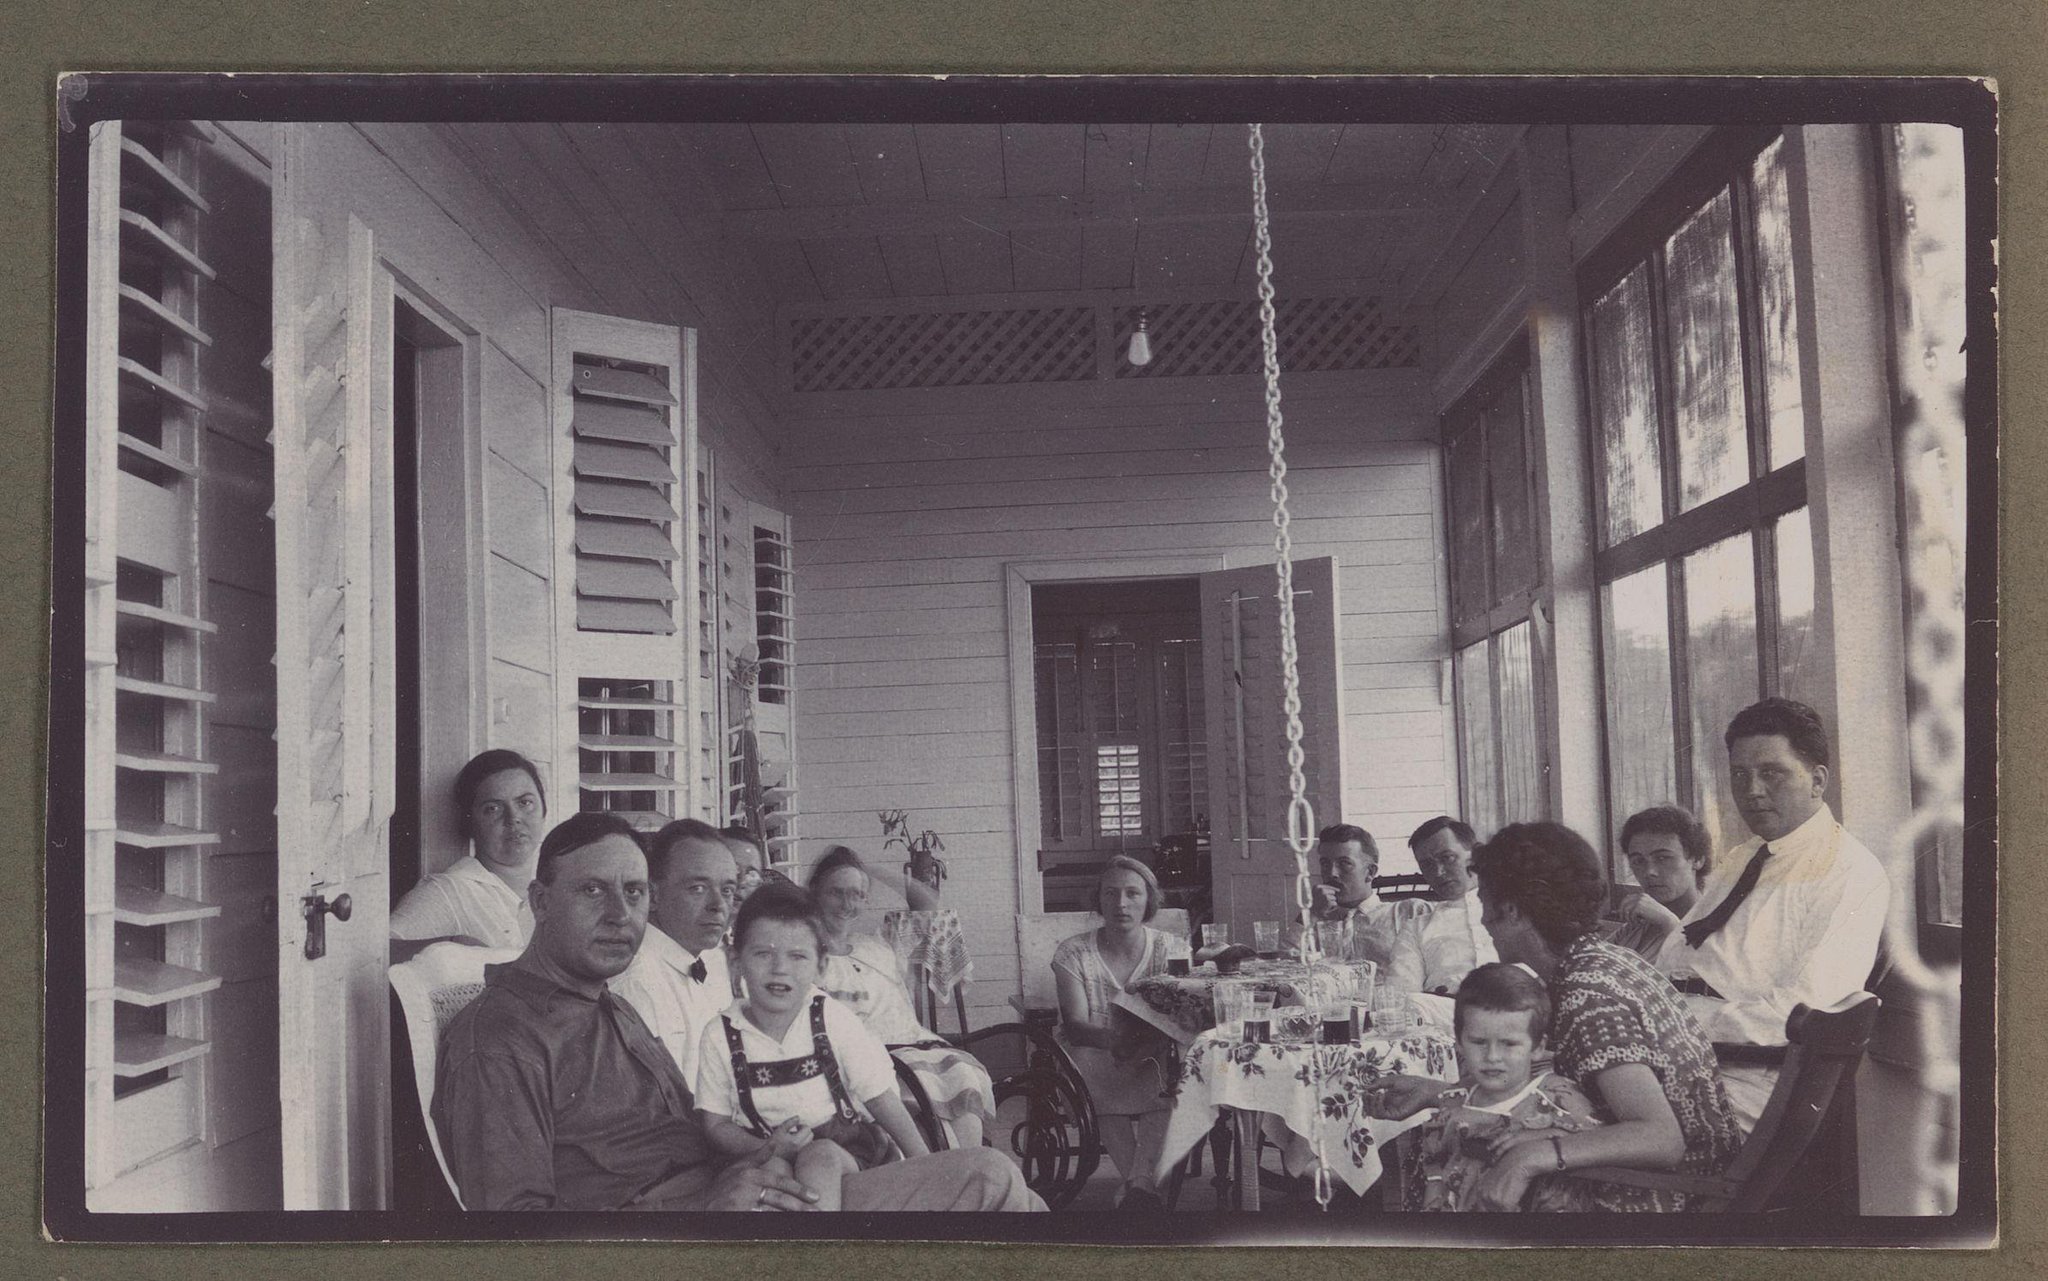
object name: photograph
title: Groepsfoto van enkele gezinnen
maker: Anonymous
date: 1925-1927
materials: photographic support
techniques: photography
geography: suriname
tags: jetten, familie, moengo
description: Groepsfoto van enkele gezinnen op een veranda. Foto op een bladzijde van een los albumblad. Onderdeel van het ensemble met foto's van de familie van ingenieur Jetten in de mijnbouwstad Moengo in Suriname.